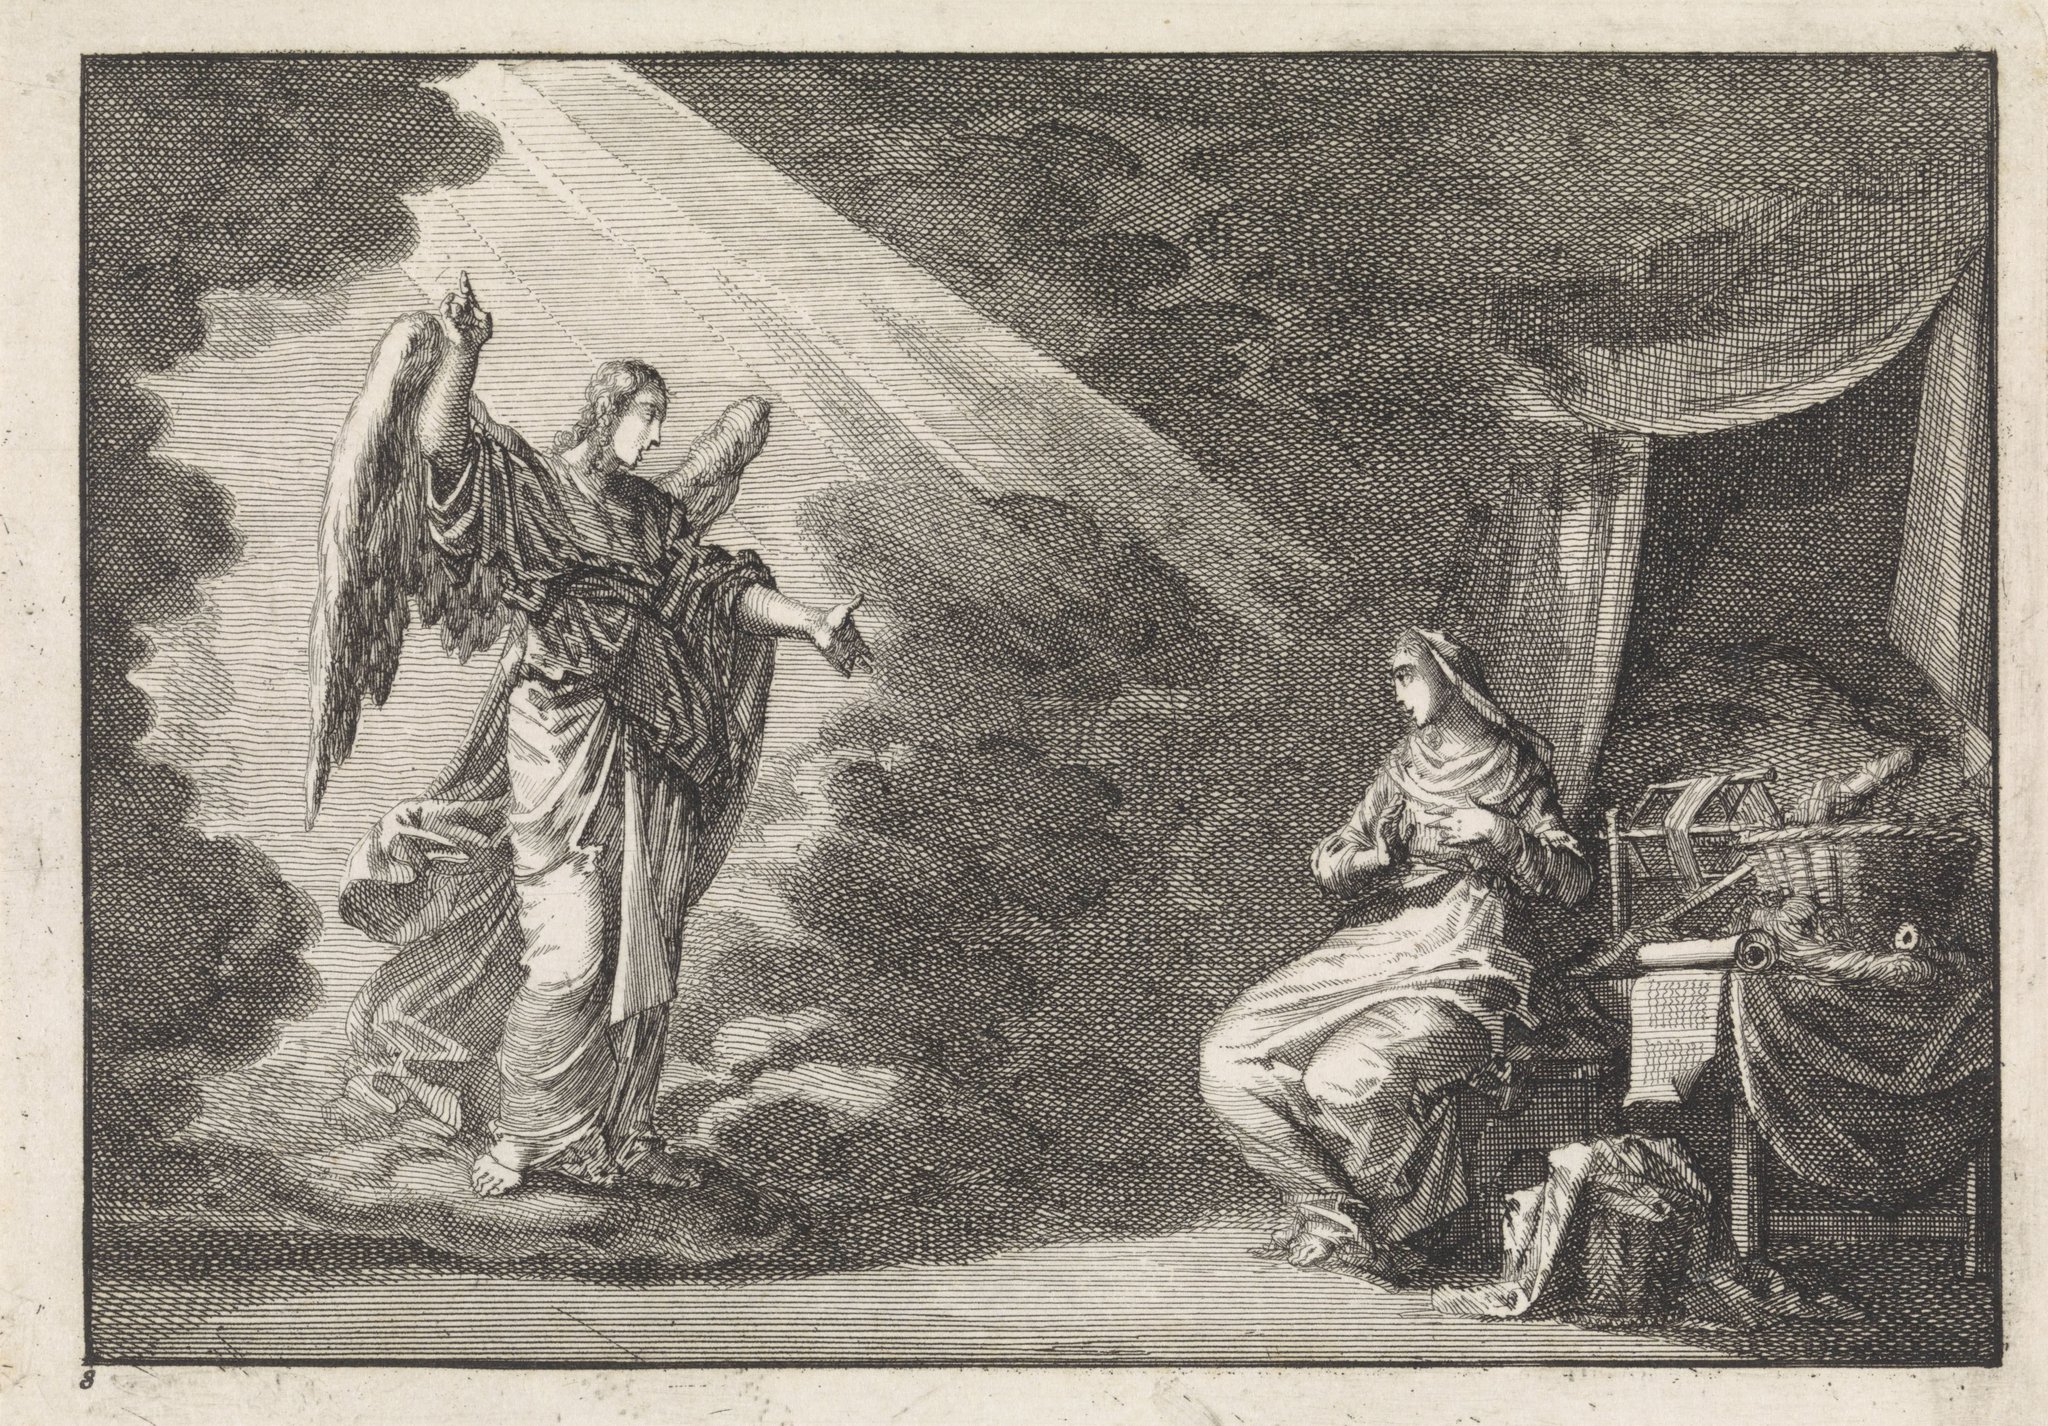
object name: print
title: Annunciatie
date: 1703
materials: paper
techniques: etching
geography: haarlem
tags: the annunciation: mary, usually reading, is visited by the angel (sometimes a woman overhears the conversation)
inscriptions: collector's mark: Lugt 2228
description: Proefdruk van een boekillustratie voor David Martin. Historie des Ouden en Nieuwen Testaments. Amsterdam, Pieter Mortier, 1703. Deel II. De boekillustraties voor de Mortierbijbel hebben verschillende staten en kopieën, waarbij de chronologische volgorde moeilijk te achterhalen valt. Als boekillustraties werden ze bovendien herhaaldelijk opnieuw gebruikt voor andere boekwerken.